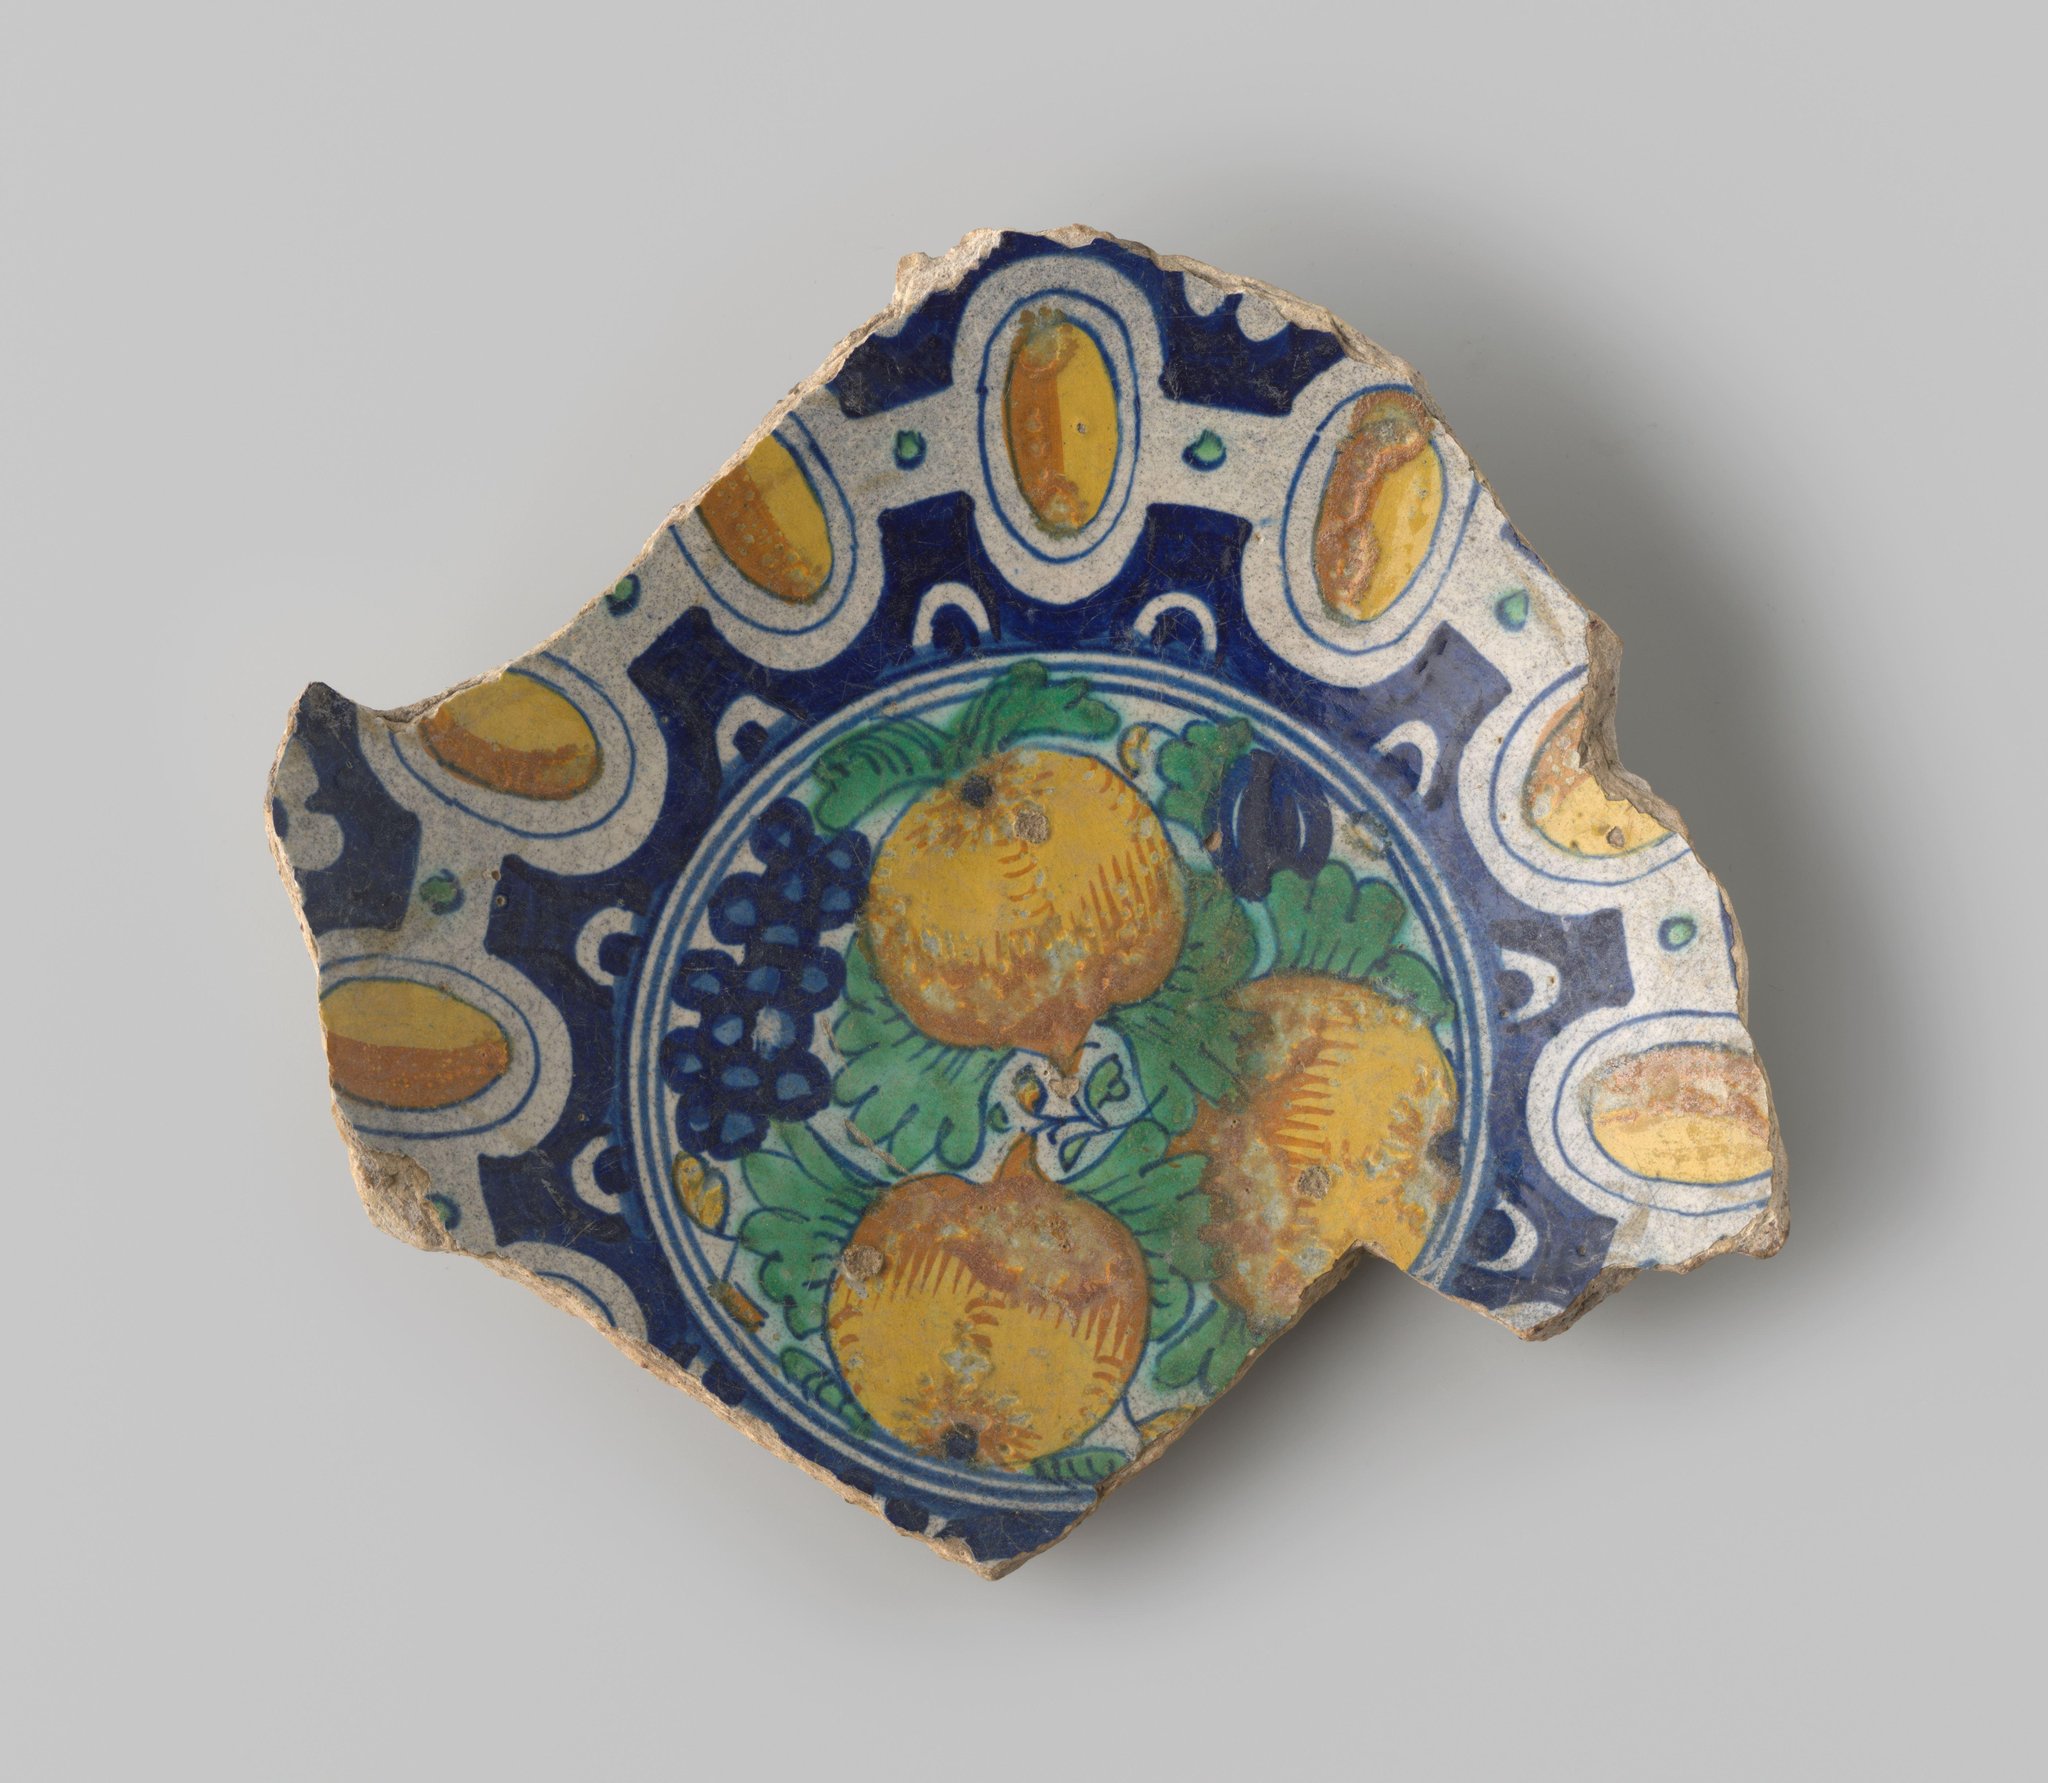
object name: fragment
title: Schotelscherf van witbakkend aardewerk, met voetring, voorzien van een schildering van fruit op het plat, en van geometrische vormen eromheen, alles in geel, oranje, groen en blauw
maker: Anonymous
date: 1600-1650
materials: earthenware, glaze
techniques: maiolica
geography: northern netherlands